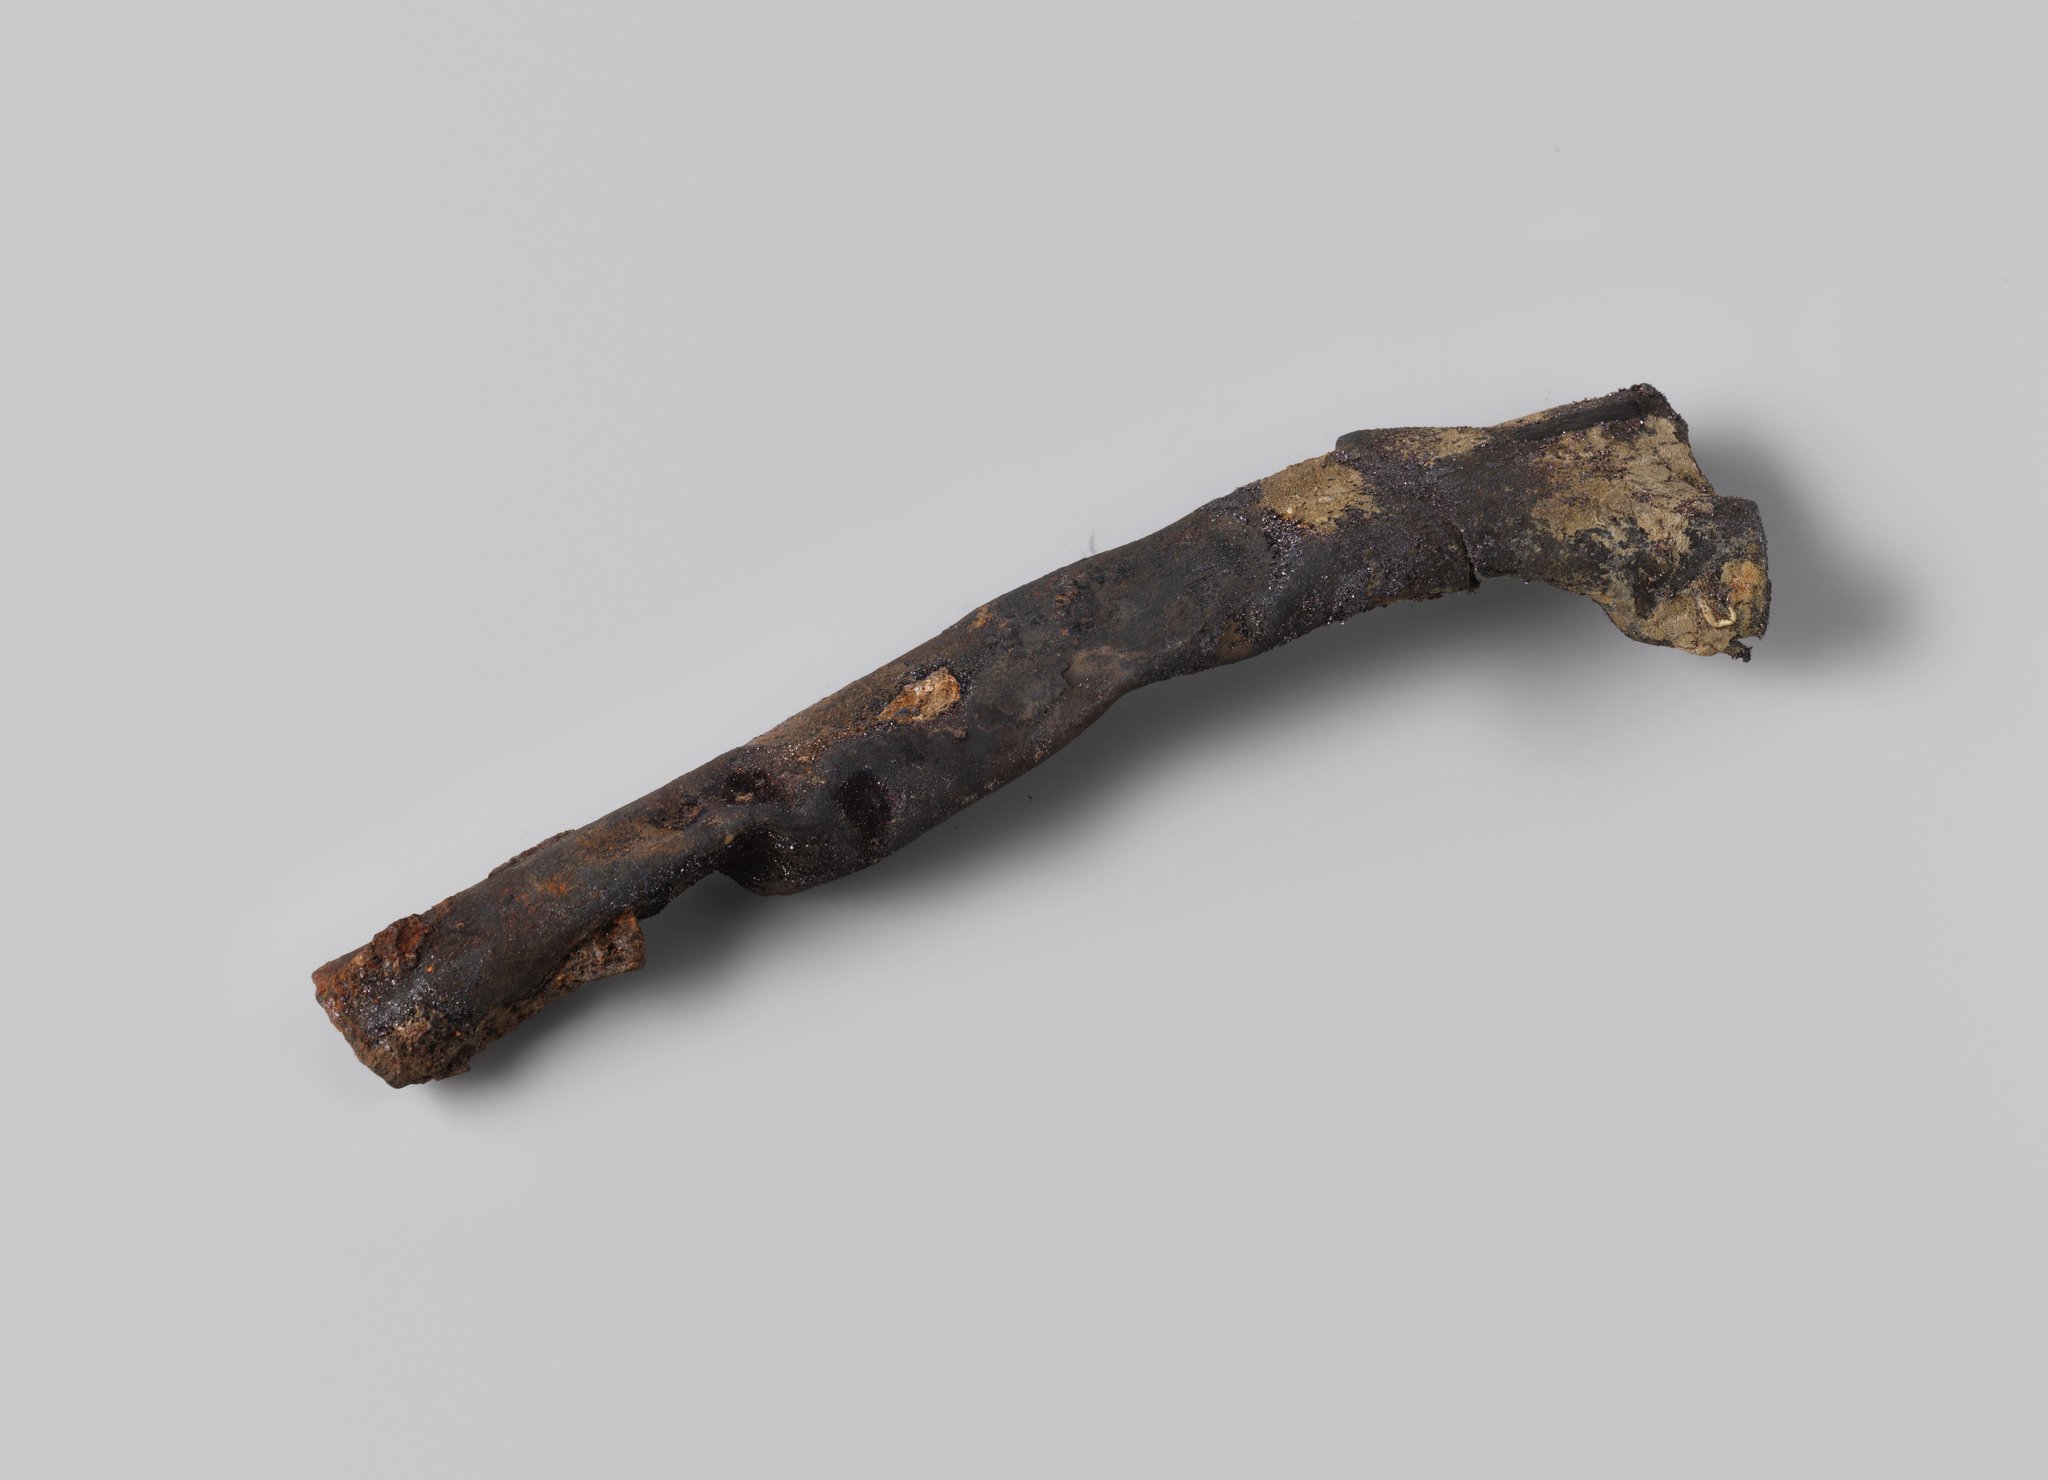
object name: fragment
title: Fragment koperen buis uit het wrak van de Oost-Indiëvaarder Hollandia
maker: Anonymous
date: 1700-1743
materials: copper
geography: netherlands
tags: verenigde oostindische compagnie, hollandia (schip), annet